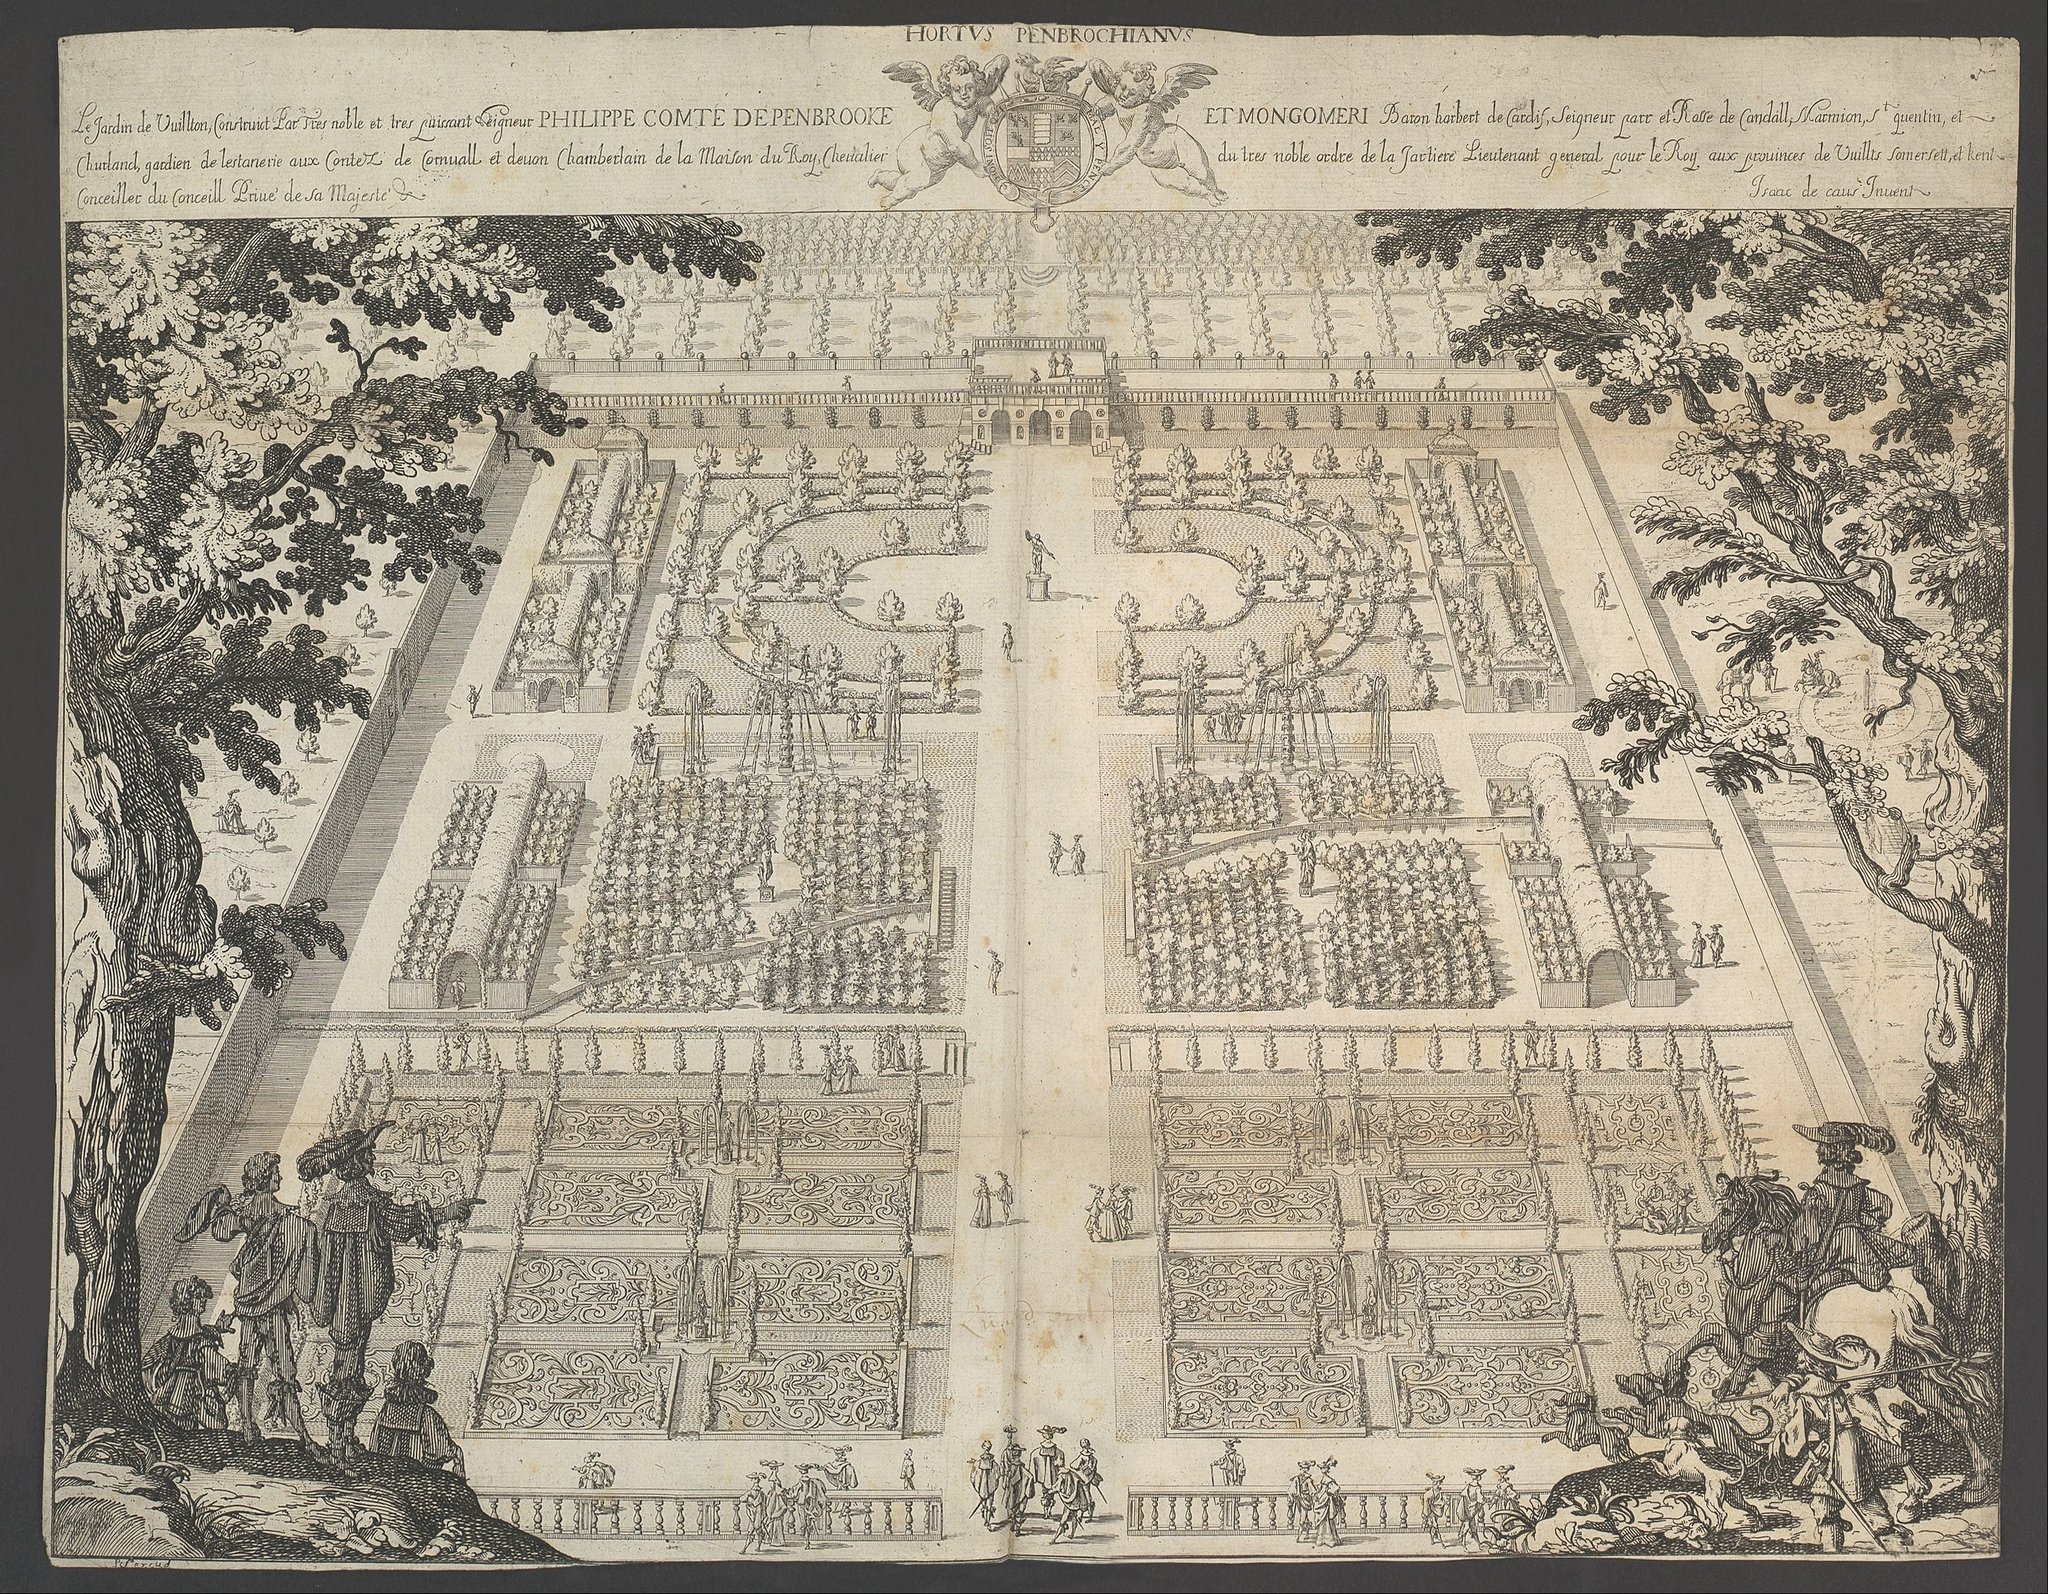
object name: book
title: Wilton Garden, plate 1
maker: isaac de caus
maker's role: designer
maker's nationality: british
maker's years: 1590-1655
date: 1640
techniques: etching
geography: england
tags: human figures,gardens,men,dogs,horses,trees,coat of arms